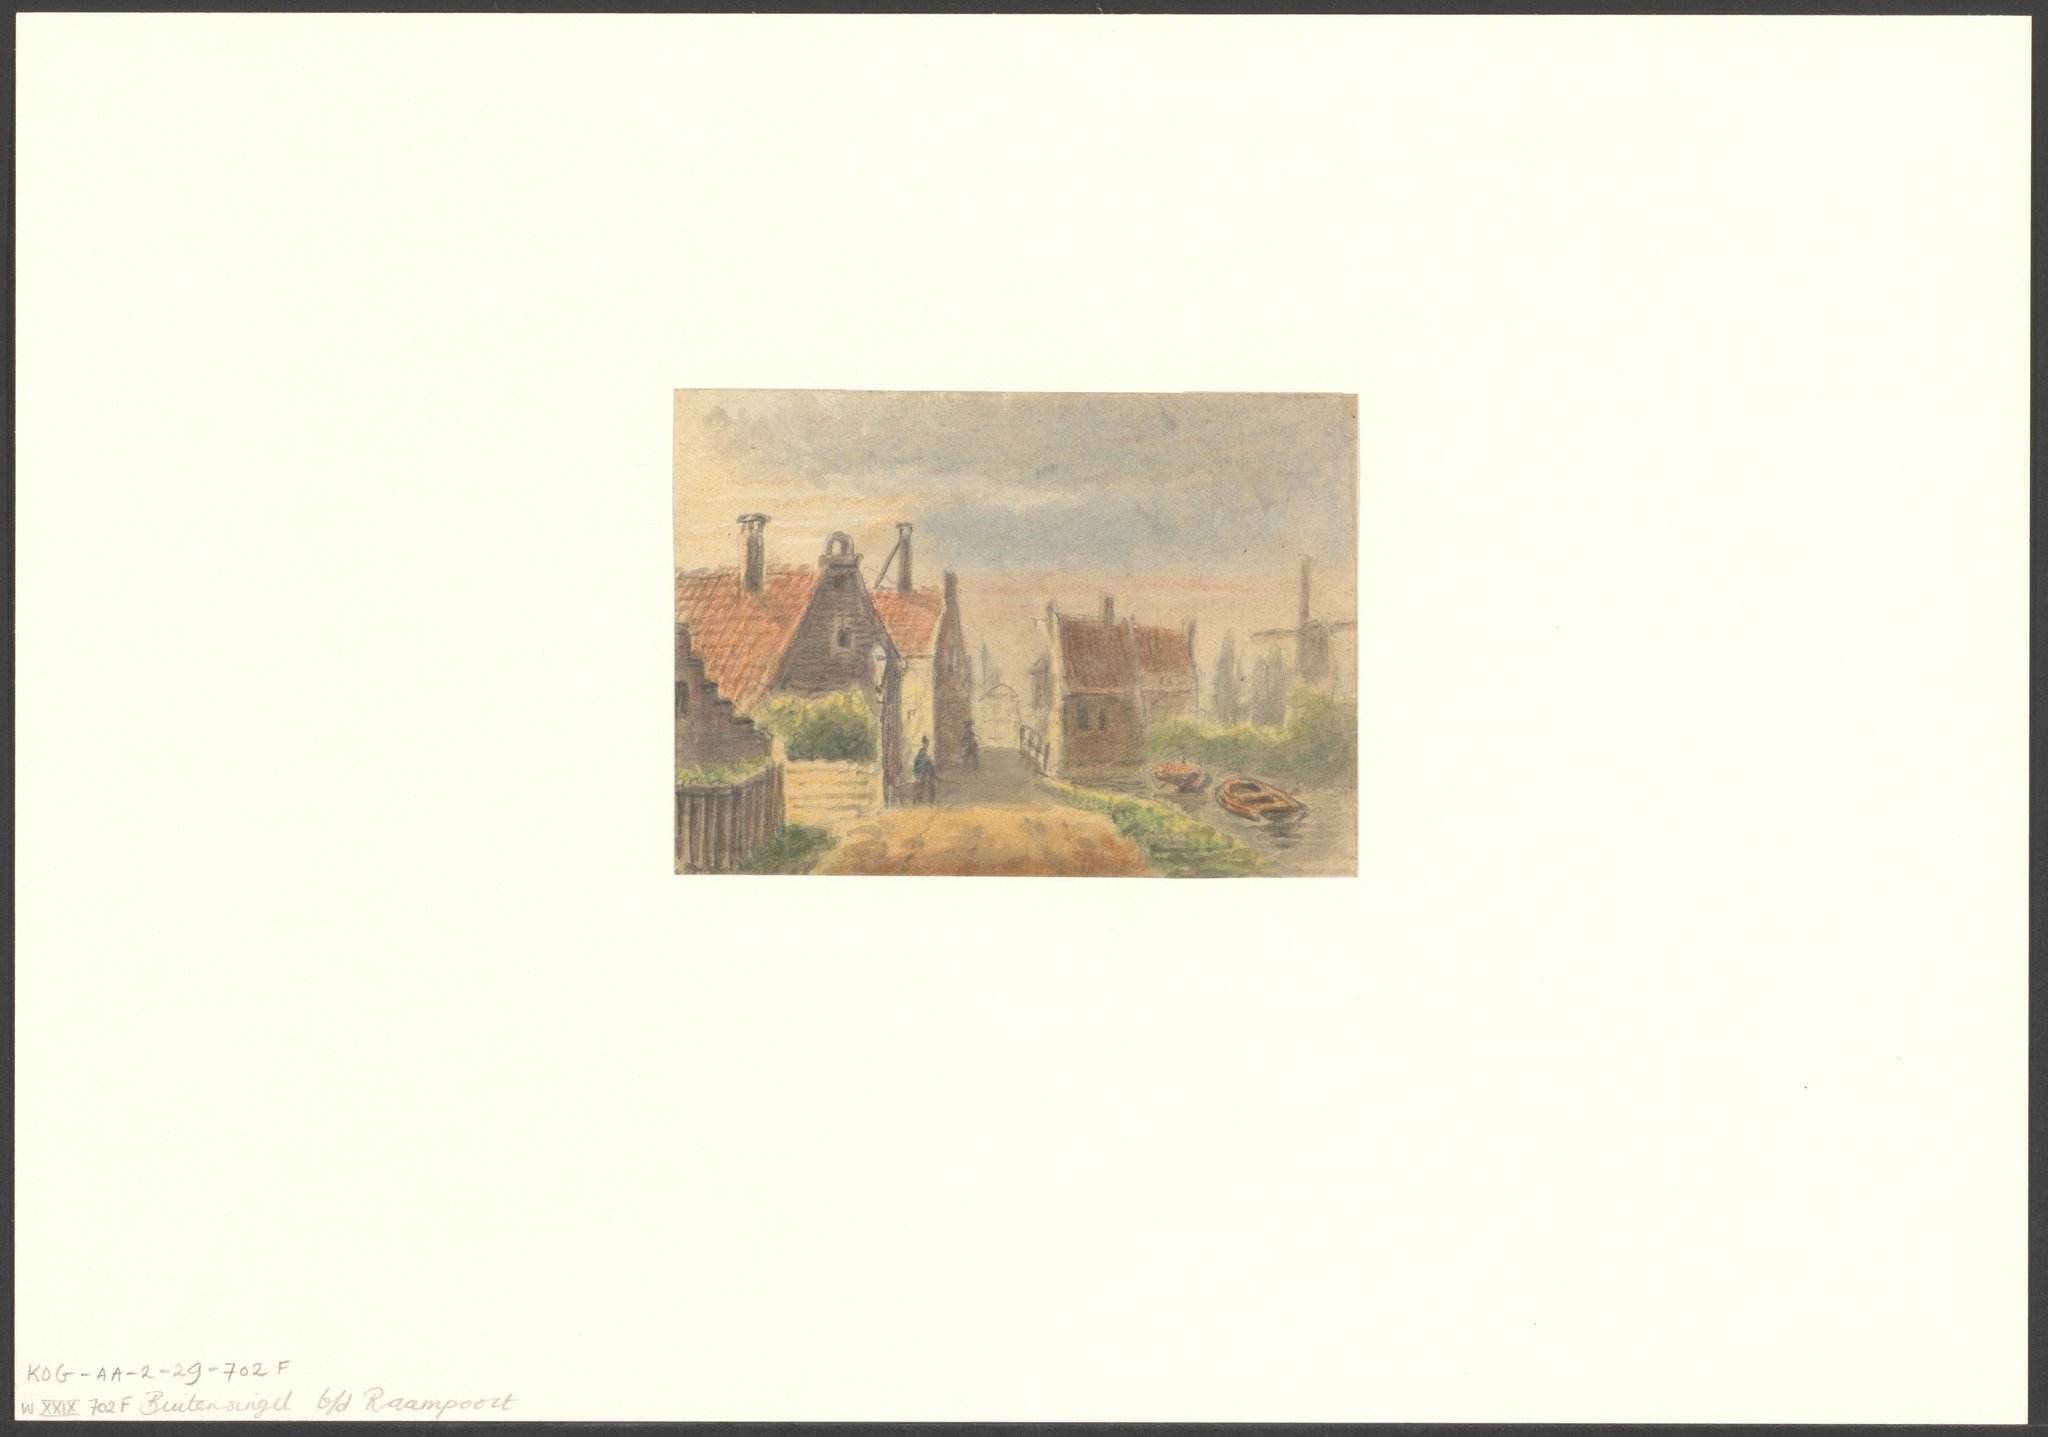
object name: drawing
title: Gezicht op een straat buiten de Raampoort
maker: Anonymous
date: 1825-1925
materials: chalk, ink, paper, pencil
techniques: brush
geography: amsterdam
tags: city-view in general; 'veduta', road, path, windmill in landscape, amsterdam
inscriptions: inscription: ‘buiten / deRaampoort’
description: Tekening binnen de Atlas Van Eck ingedeeld op wijknummer 29.